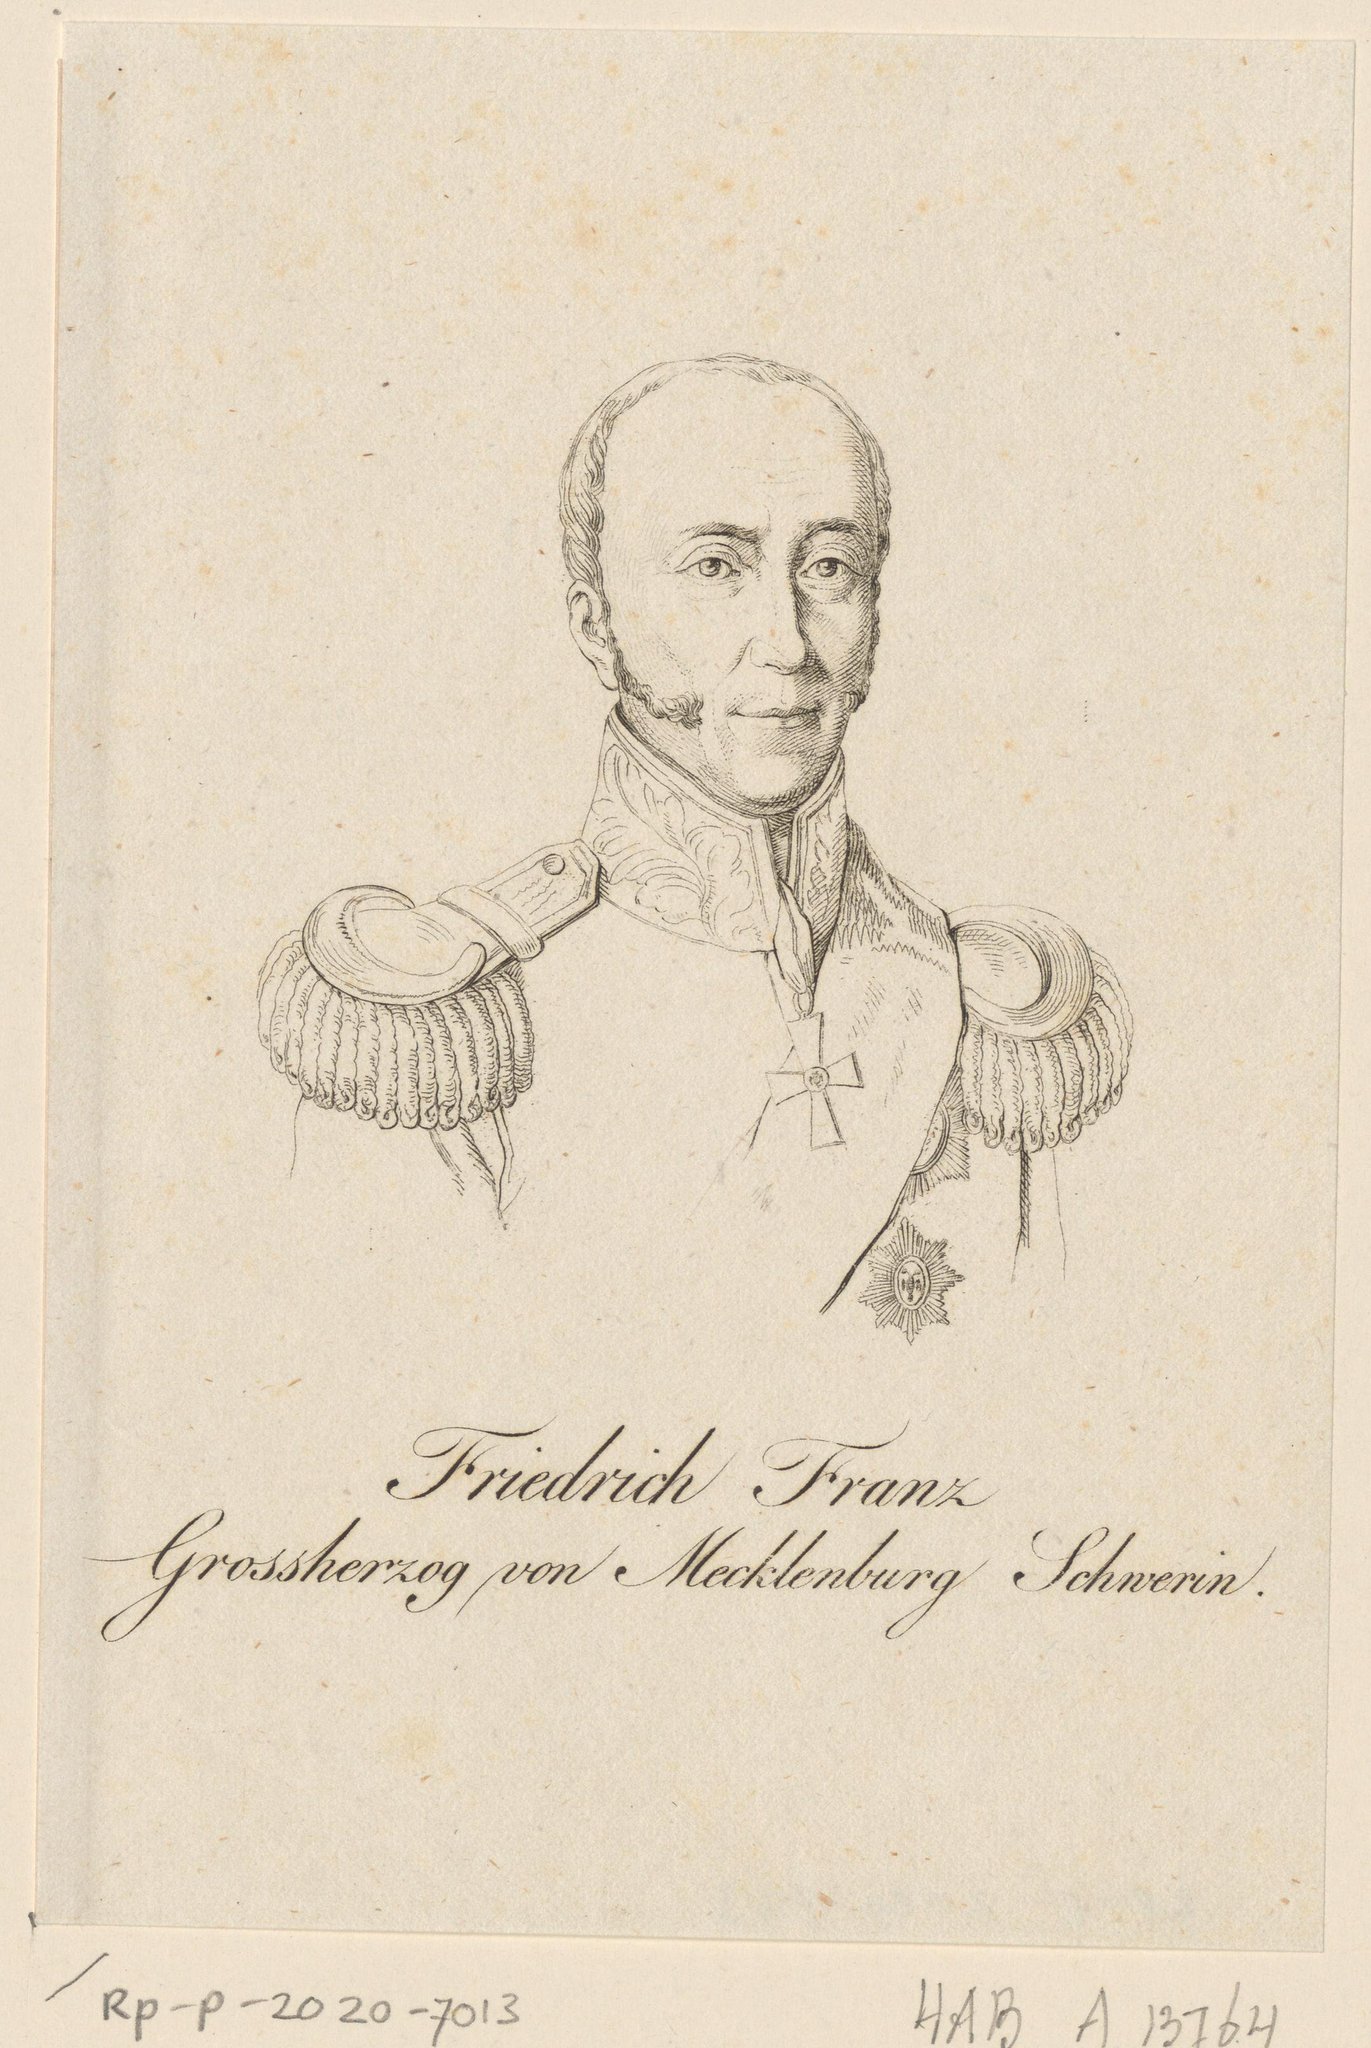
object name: print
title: Portret van Frederik Frans I van Mecklenburg-Schwerin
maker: Anonymous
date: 1815-1899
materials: paper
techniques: etching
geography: germany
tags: historical persons